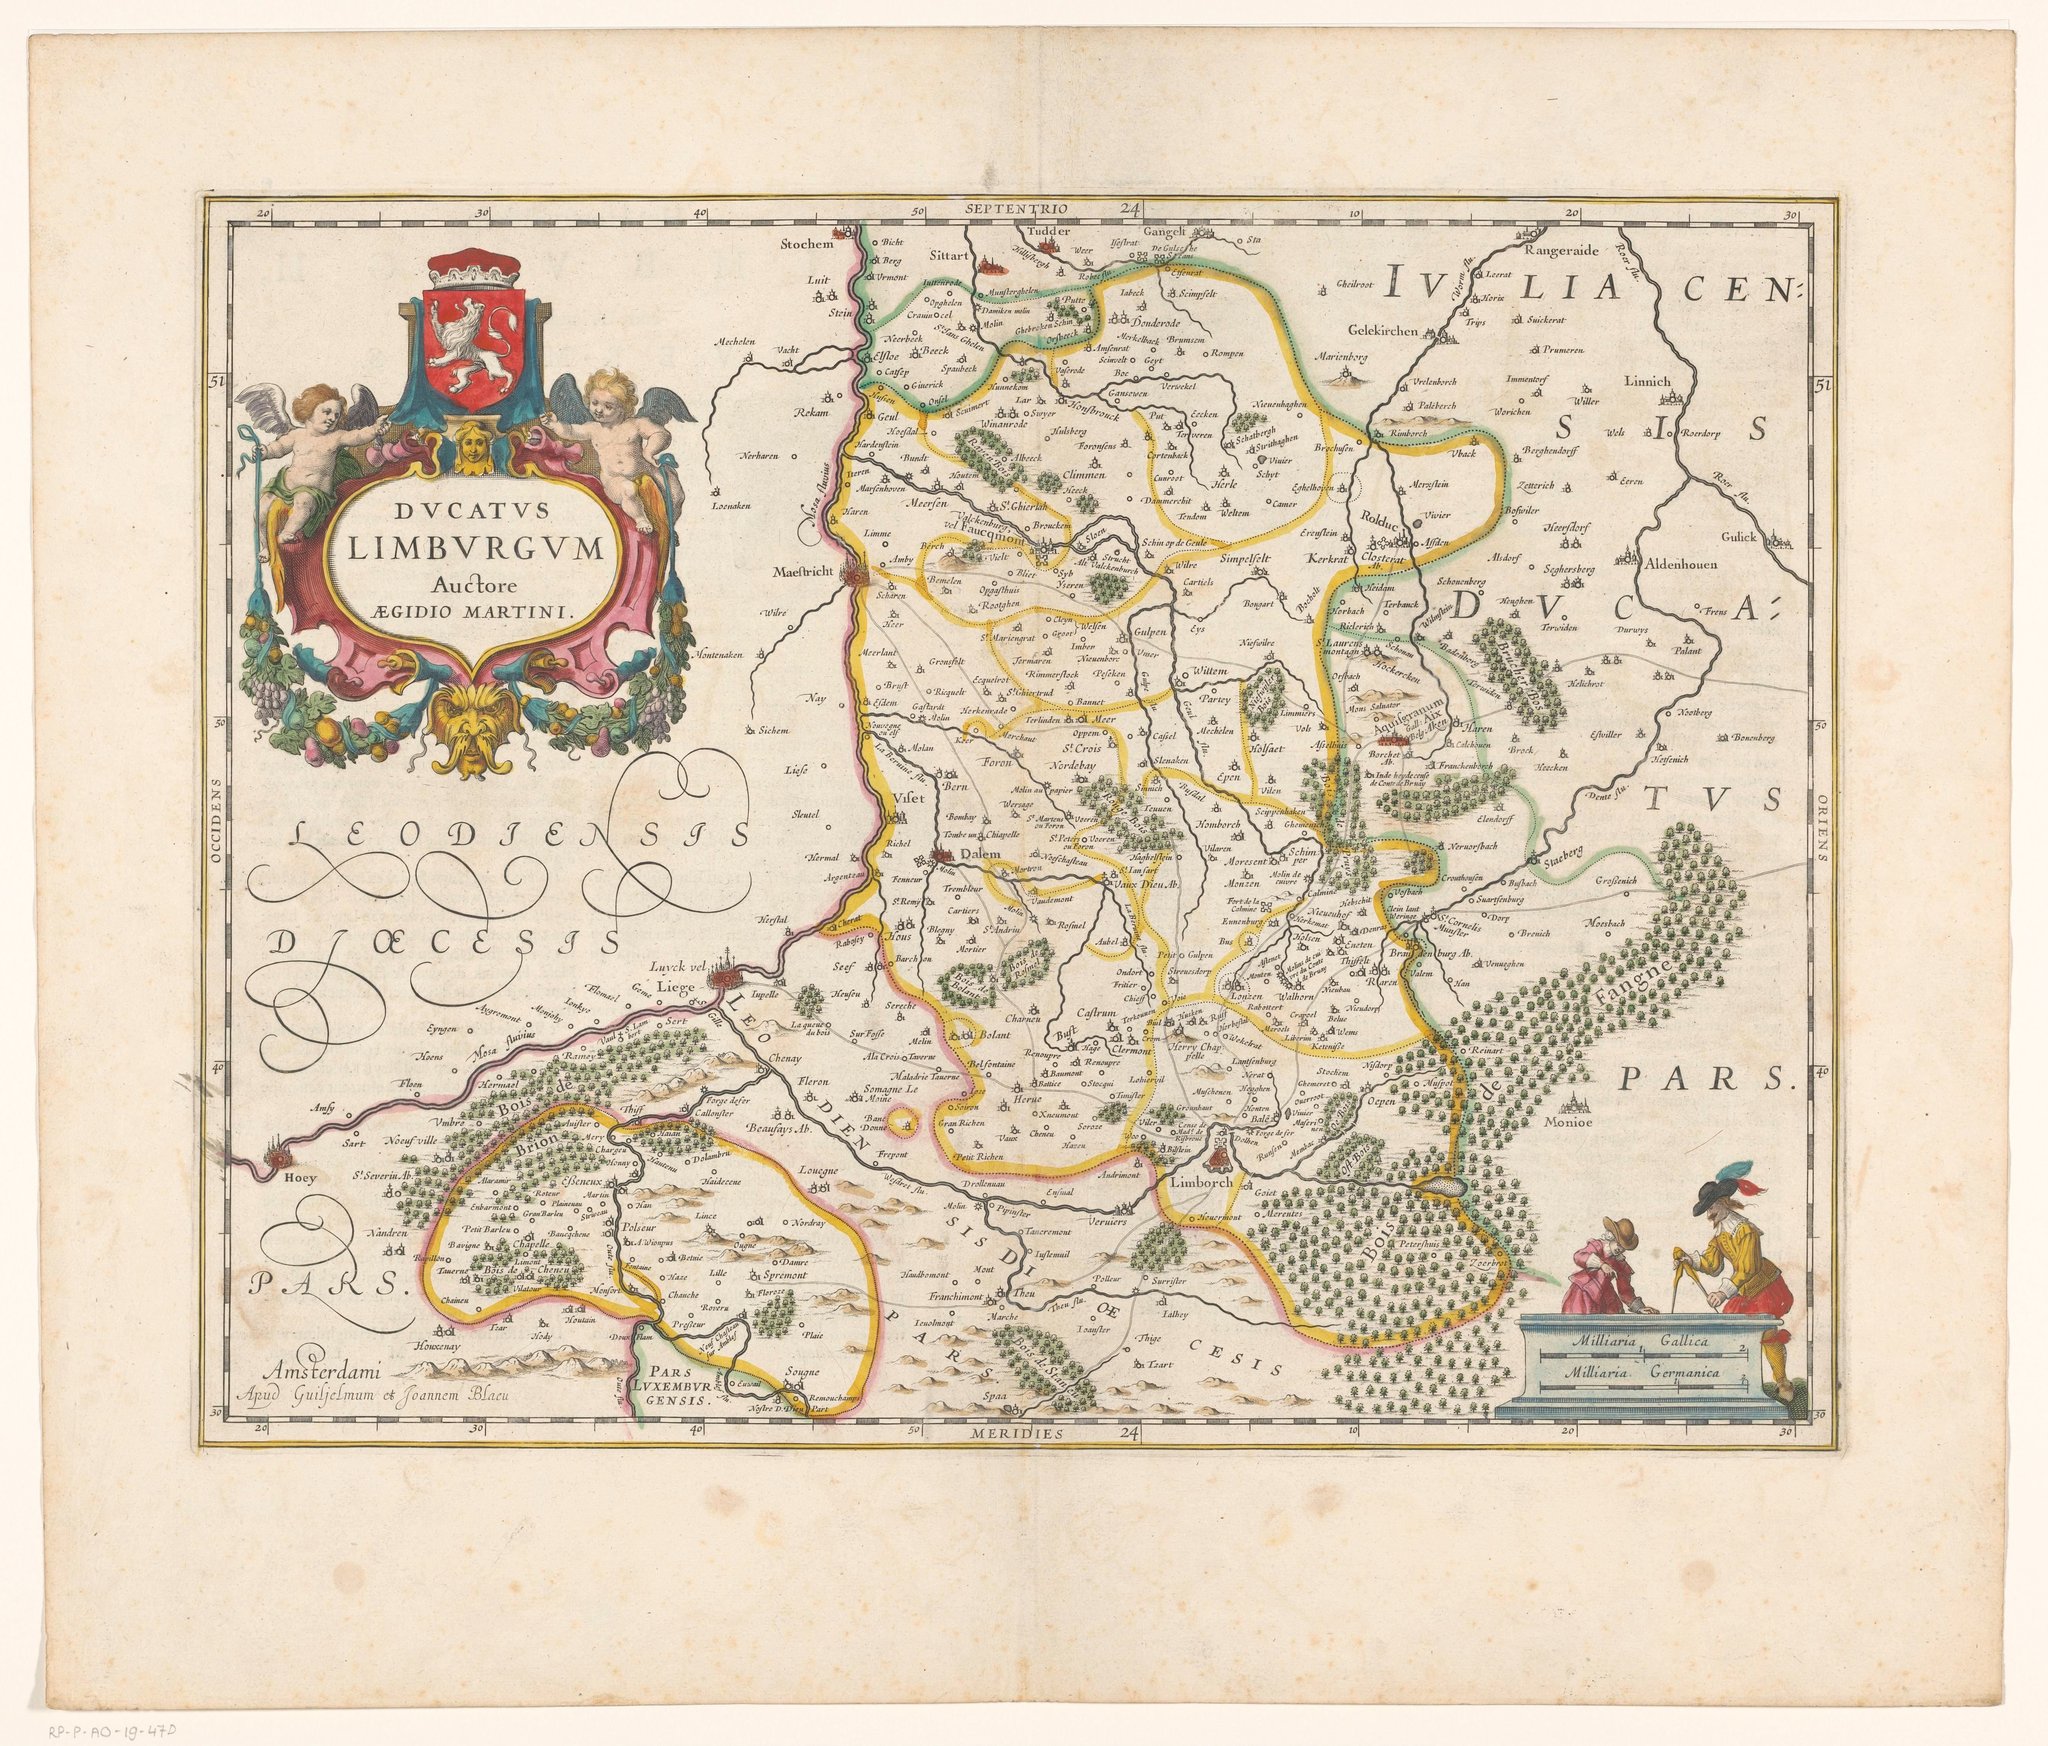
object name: print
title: Ducatus Limburgum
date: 1664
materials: paper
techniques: engraving, letterpress printing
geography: amsterdam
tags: maps of separate countries or regions, coat of arms (as symbol of the state, etc.) (+ province; provincial)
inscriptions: collector's mark: Lugt 2228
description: Kaart van het hertogdom Limburg. Linksboven de titelcartouche met bovenin het wapen van het hertogdom Limburg. Rechtsonder een cartouche met twee schaalstokken: 2 Milliaria Gallica / 2 Milliaria Germanica. De kaart is voorzien van een gradenverdeling langs de randen. Met Nederlandse tekst op verso.